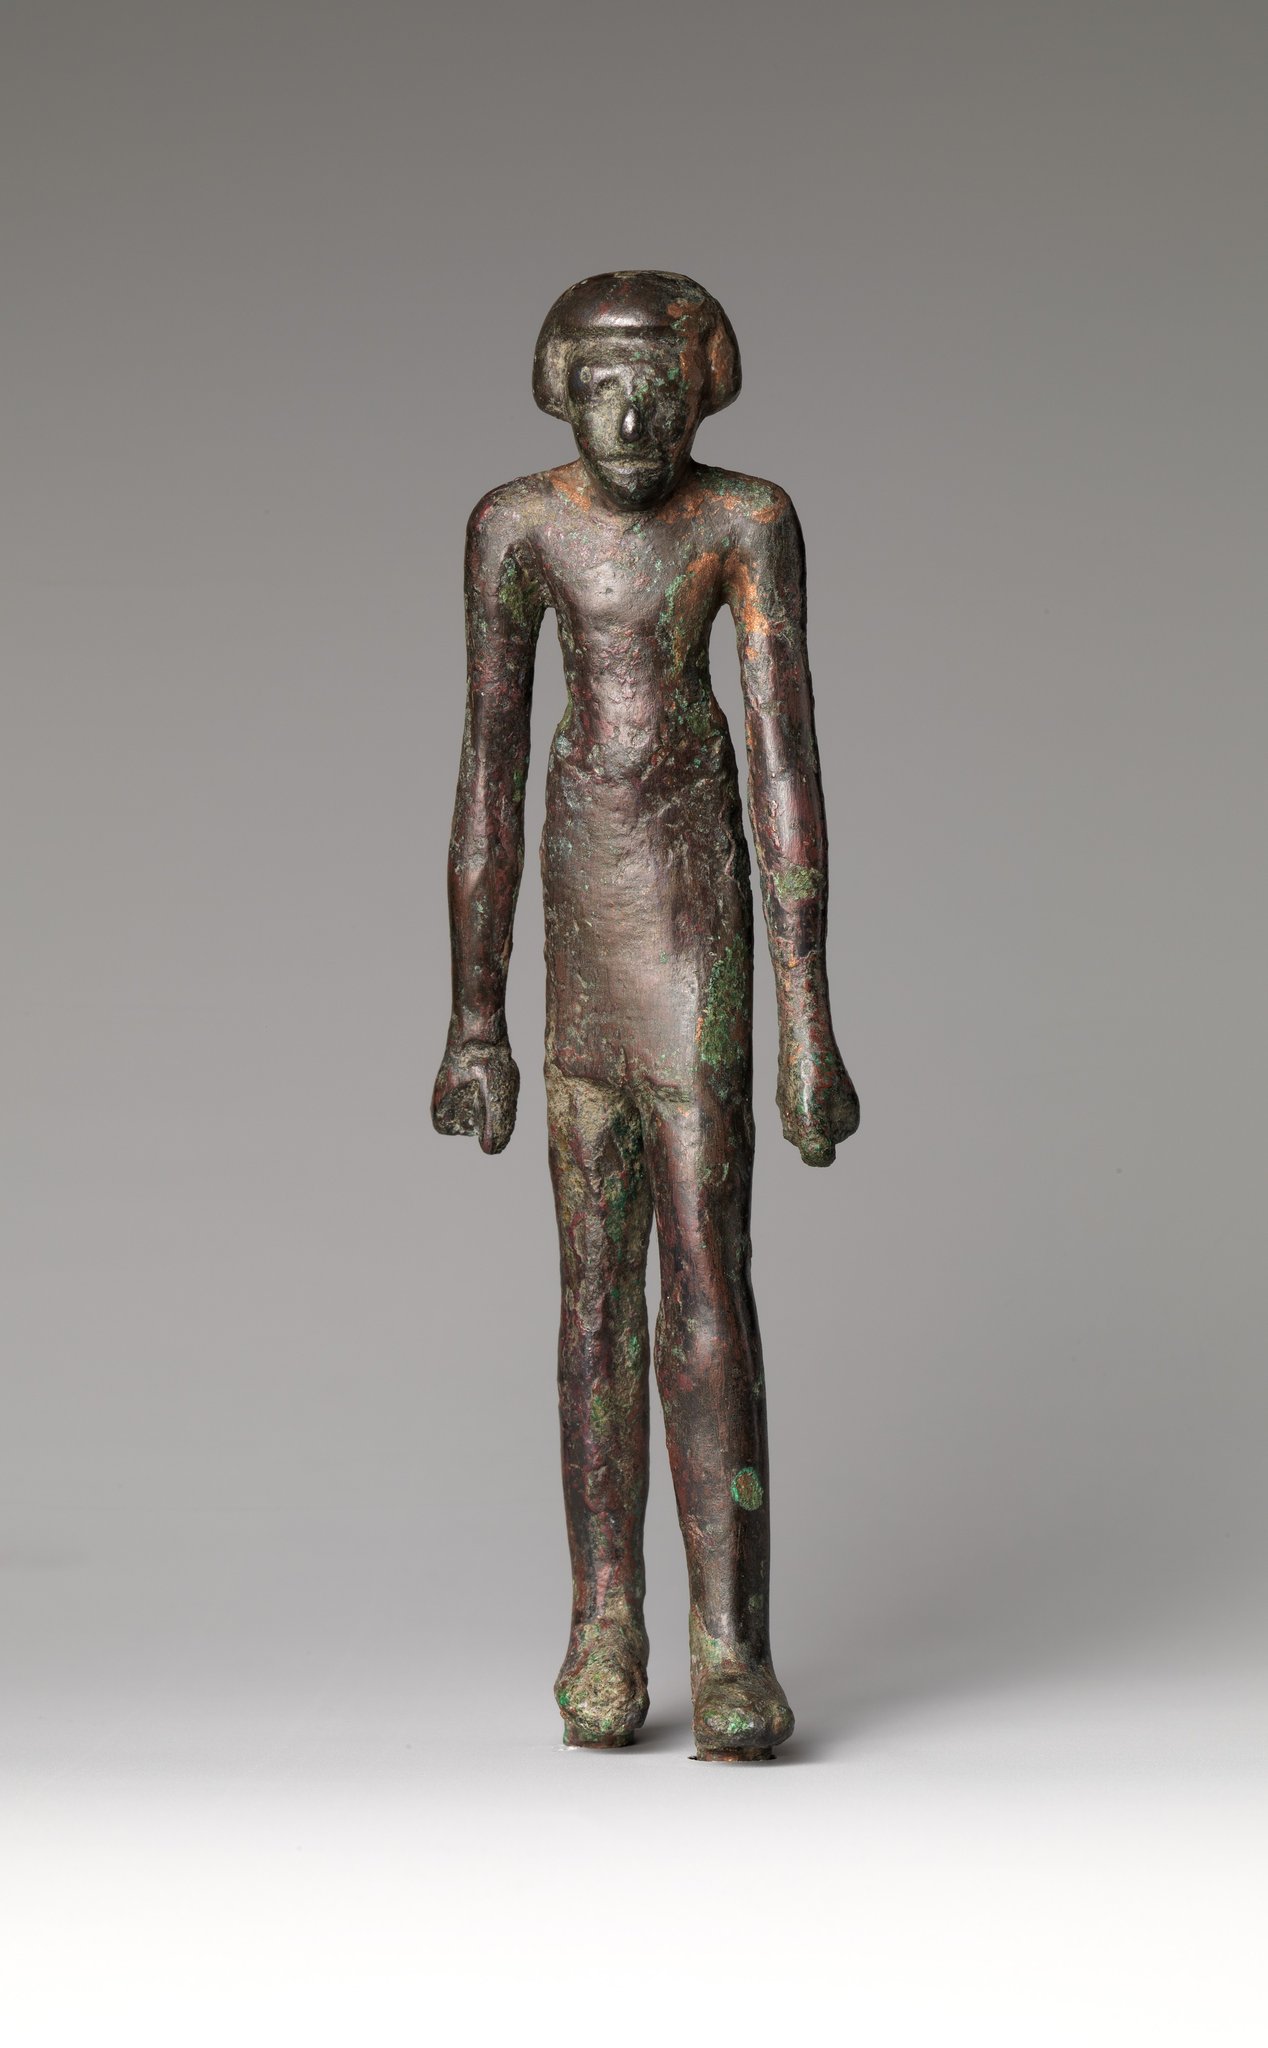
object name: statuette, striding man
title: Striding Man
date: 2100-1950 BCE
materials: copper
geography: egypt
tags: men,portraits